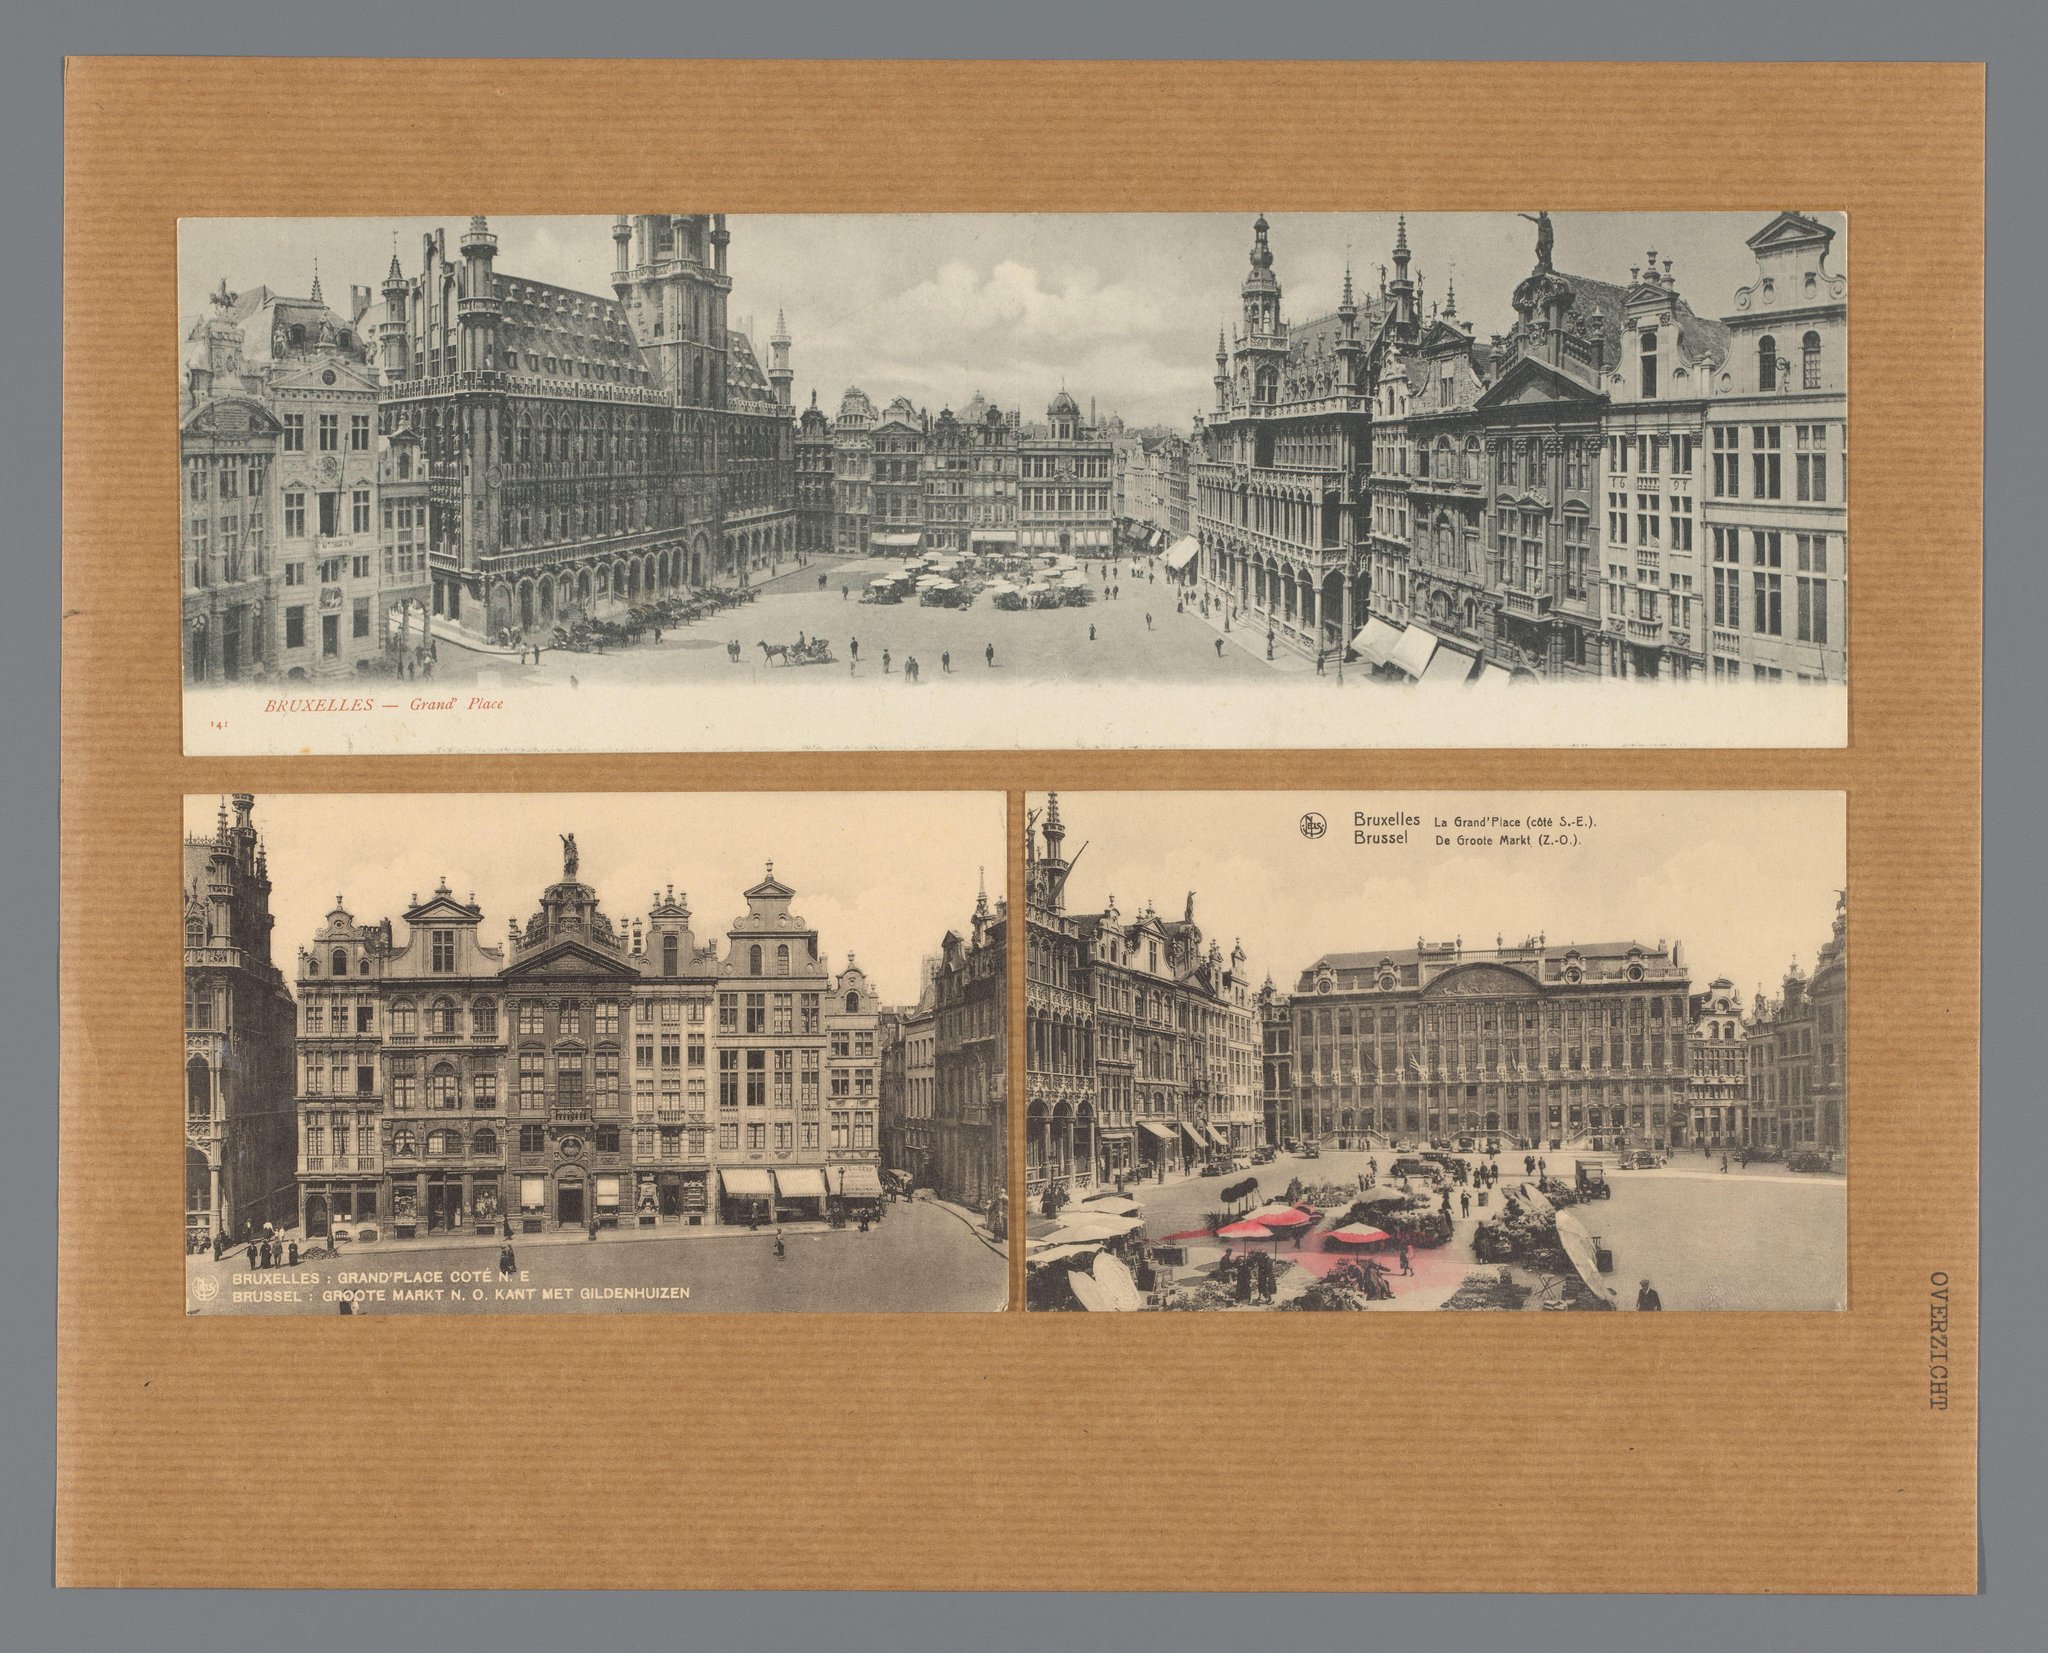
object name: photograph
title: Brussel. Grote markt.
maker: Anonymous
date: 1860-1925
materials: photographic support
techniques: photograph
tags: grote markt